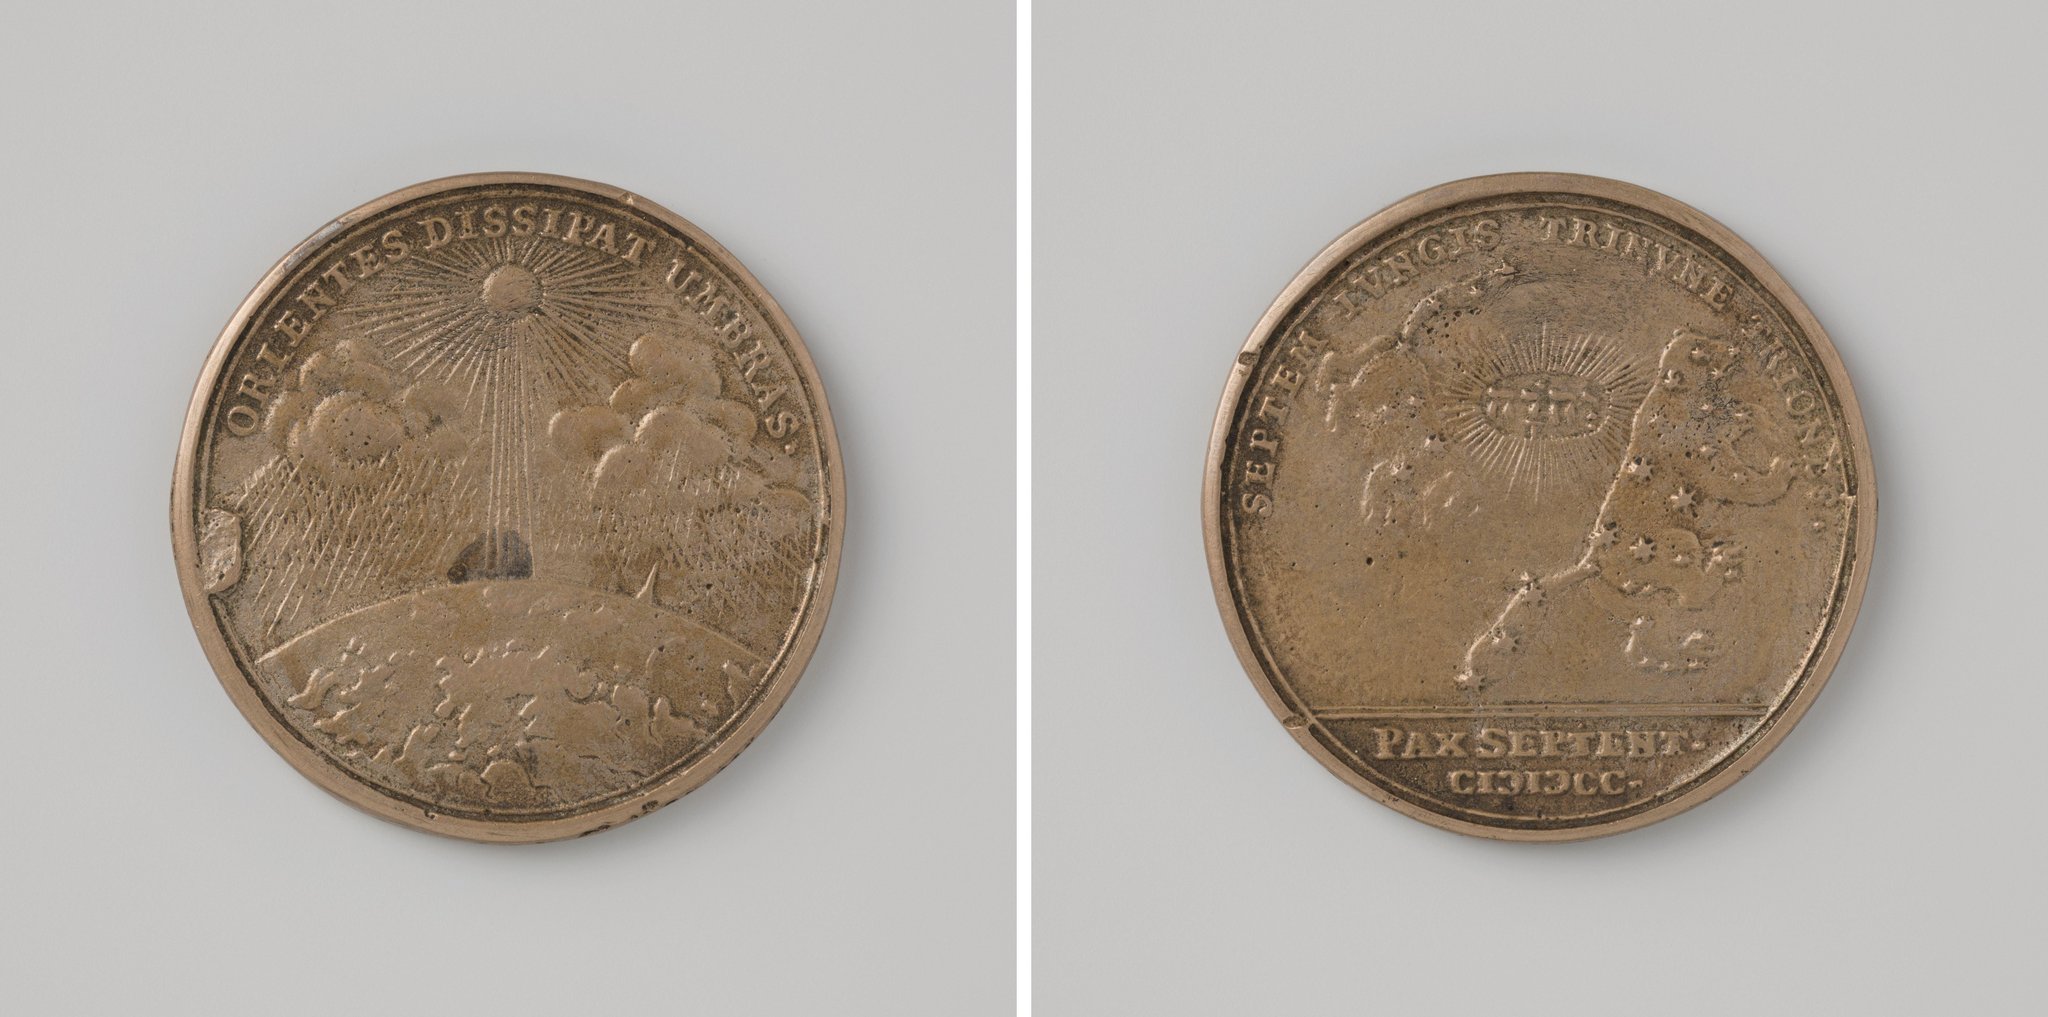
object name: history medal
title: Vrede van Traventhal in de Grote Noordse Oorlog 1700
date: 1700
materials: brass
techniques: casting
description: Gegoten messing penning, op de voorzijde de zon die doorbreekt boven Noord Europa, met omschrift, op de keerzijde Grote en Kleine Beer rond de Hebreeuwse naam Gods, met omschrift en afsnedetekst.